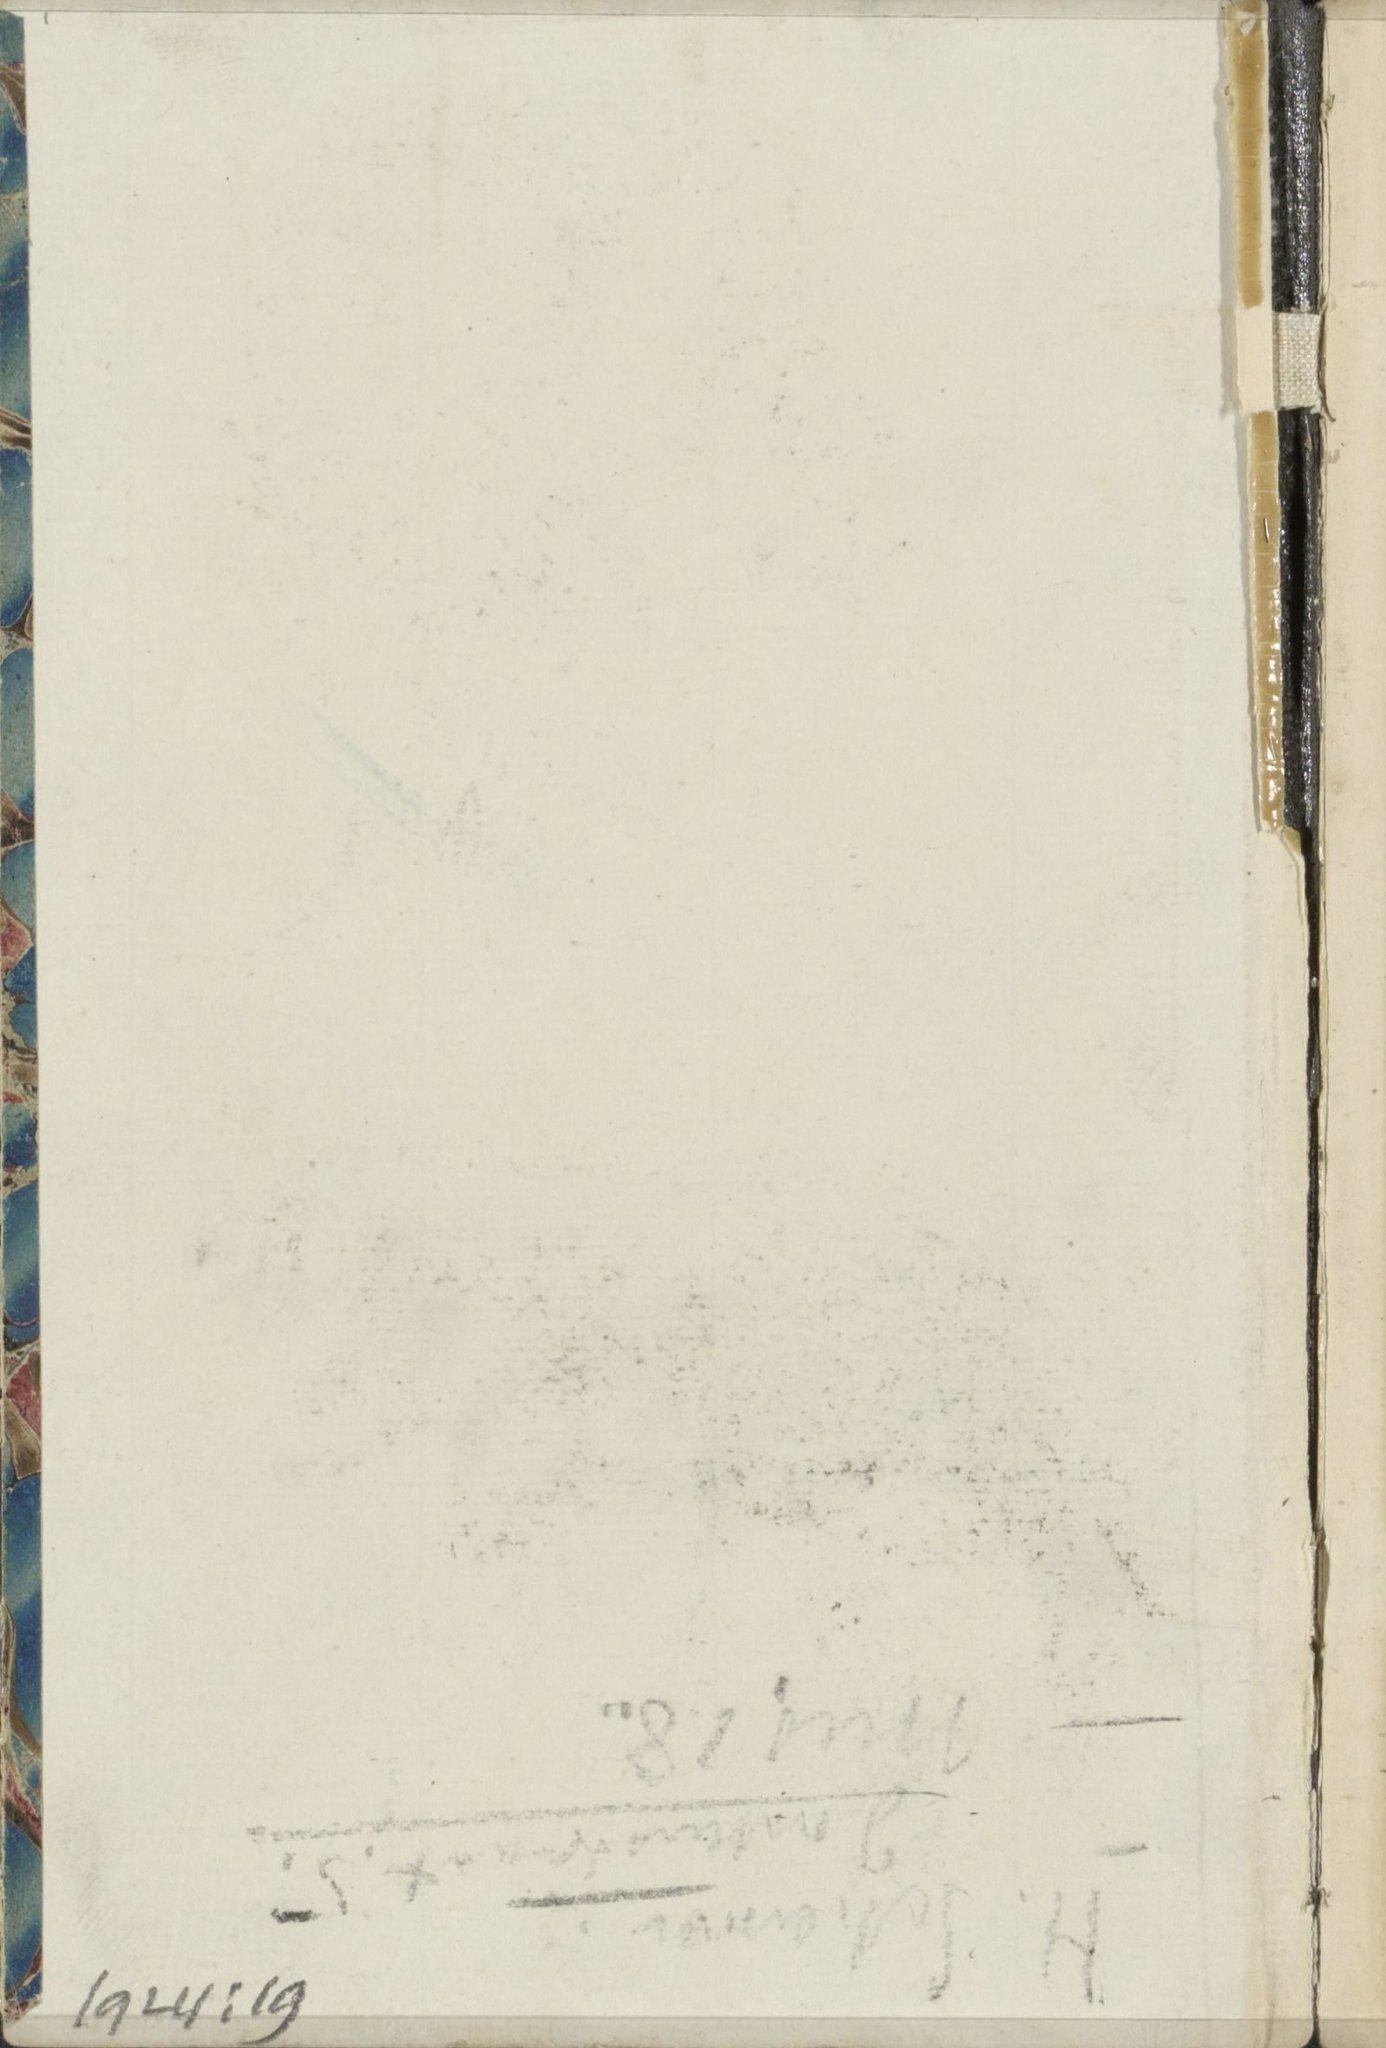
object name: endleaf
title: Annotatie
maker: george hendrik breitner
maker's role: draughtsman, painter, print maker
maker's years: 1857-1923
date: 1886-1898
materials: chalk, paper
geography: amsterdam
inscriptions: annotation: ‘[...]’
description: Pagina 1, voorste schutblad, uit een schetsboek met 18 bladen.